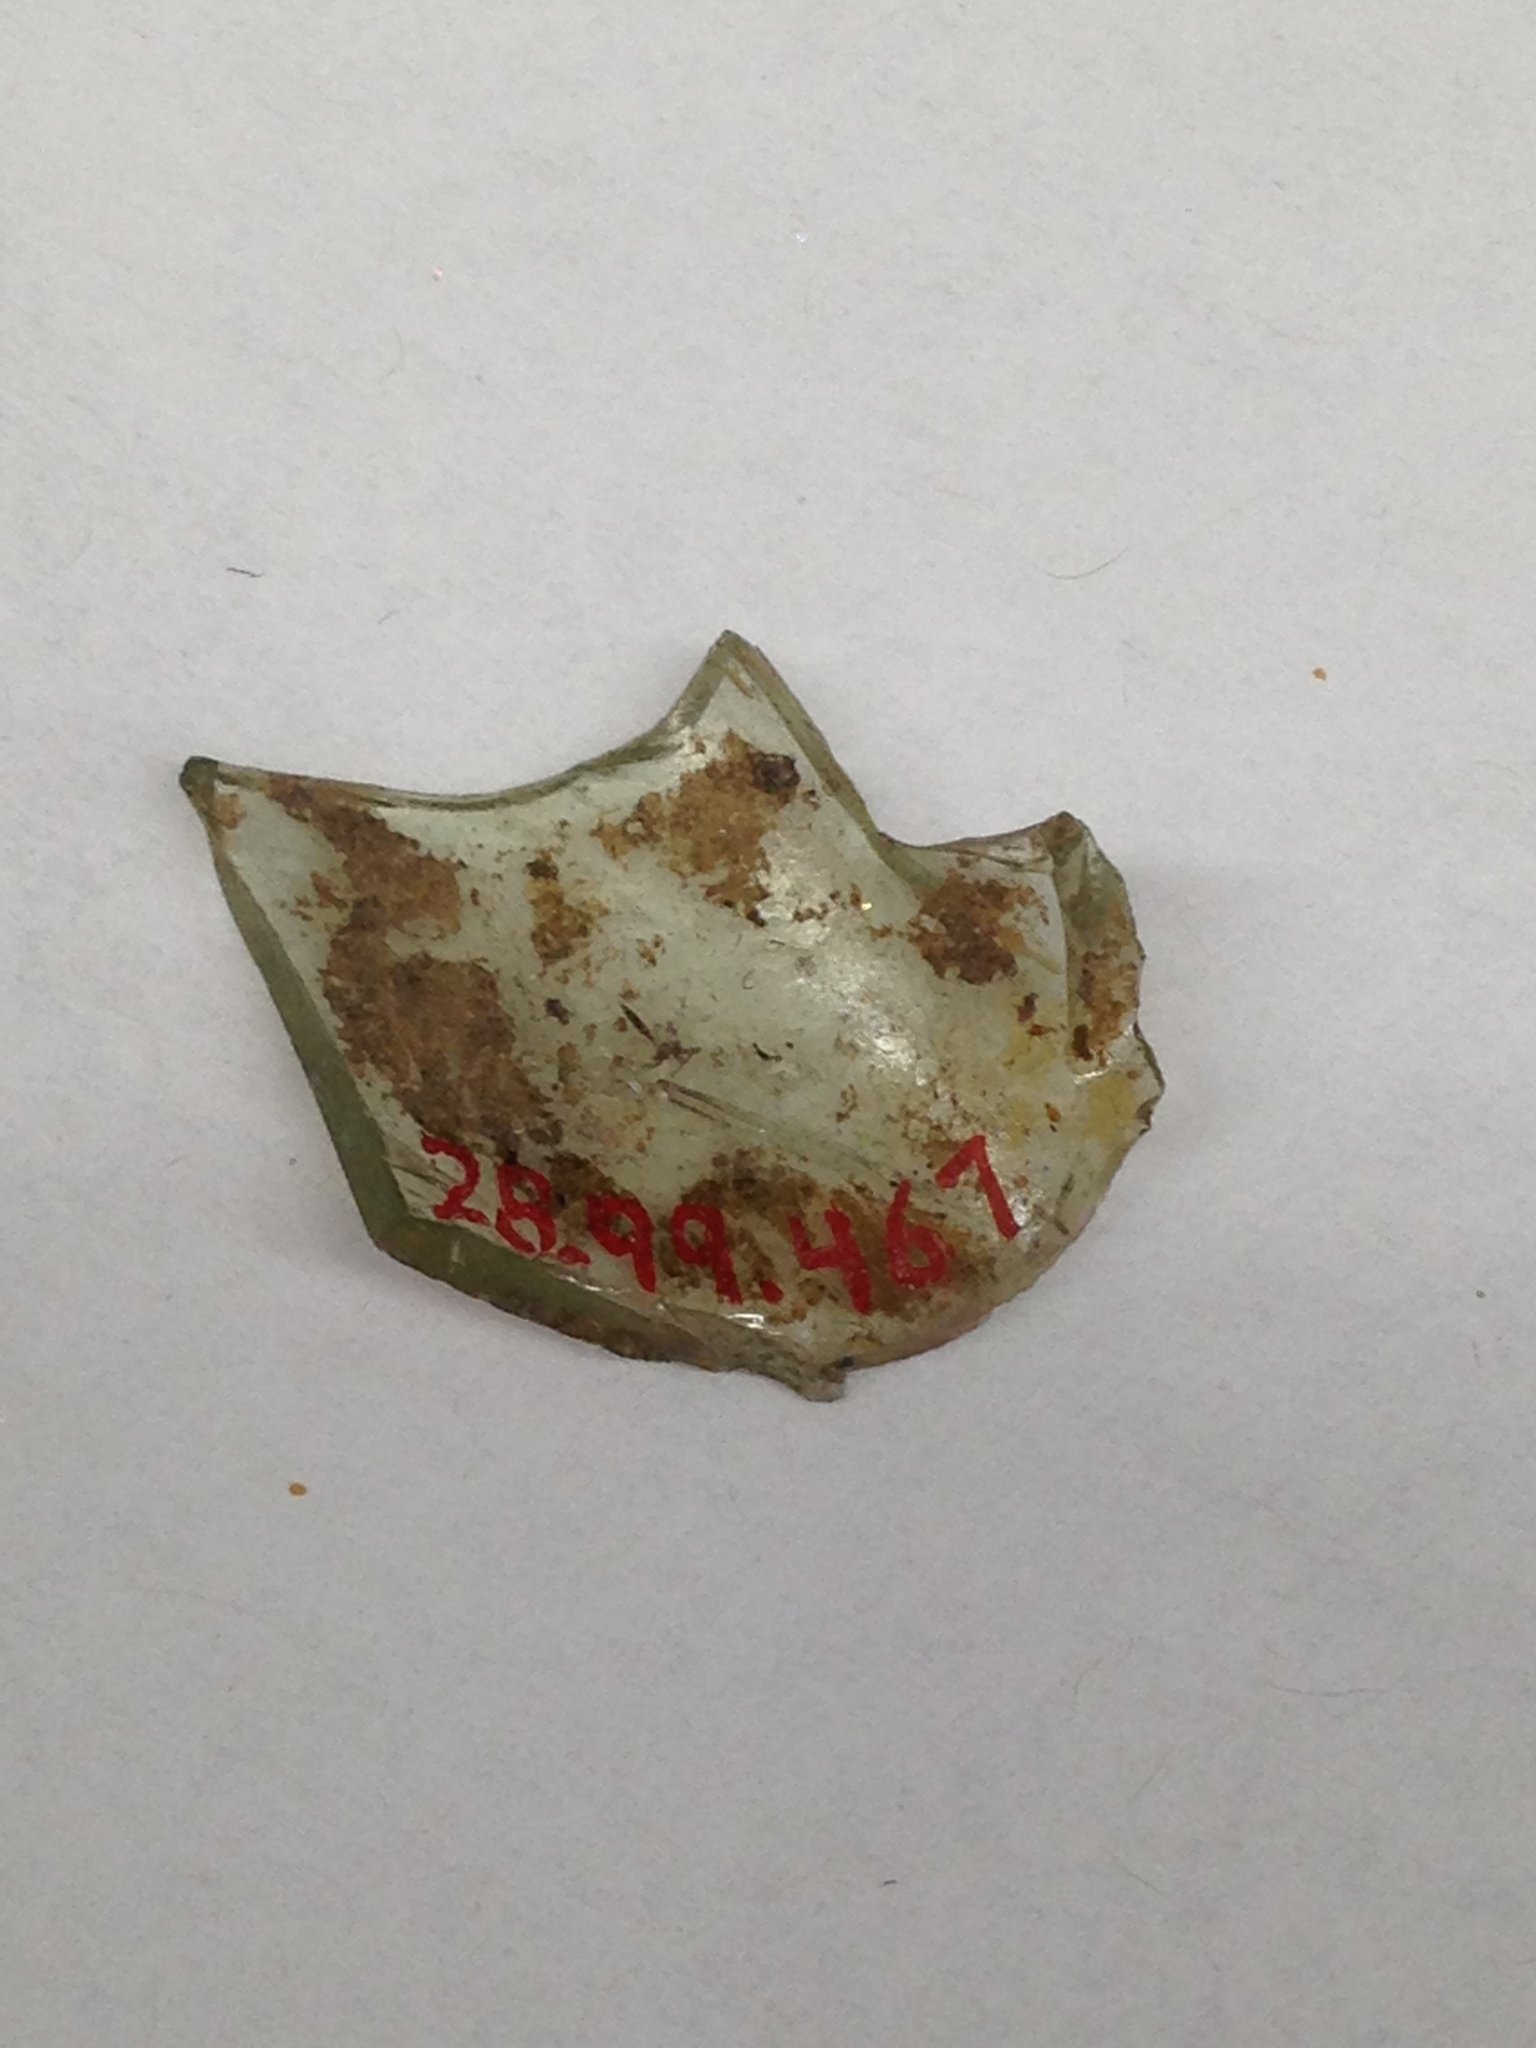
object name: fragment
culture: european or middle eastern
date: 1150-1250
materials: ceramic, glass